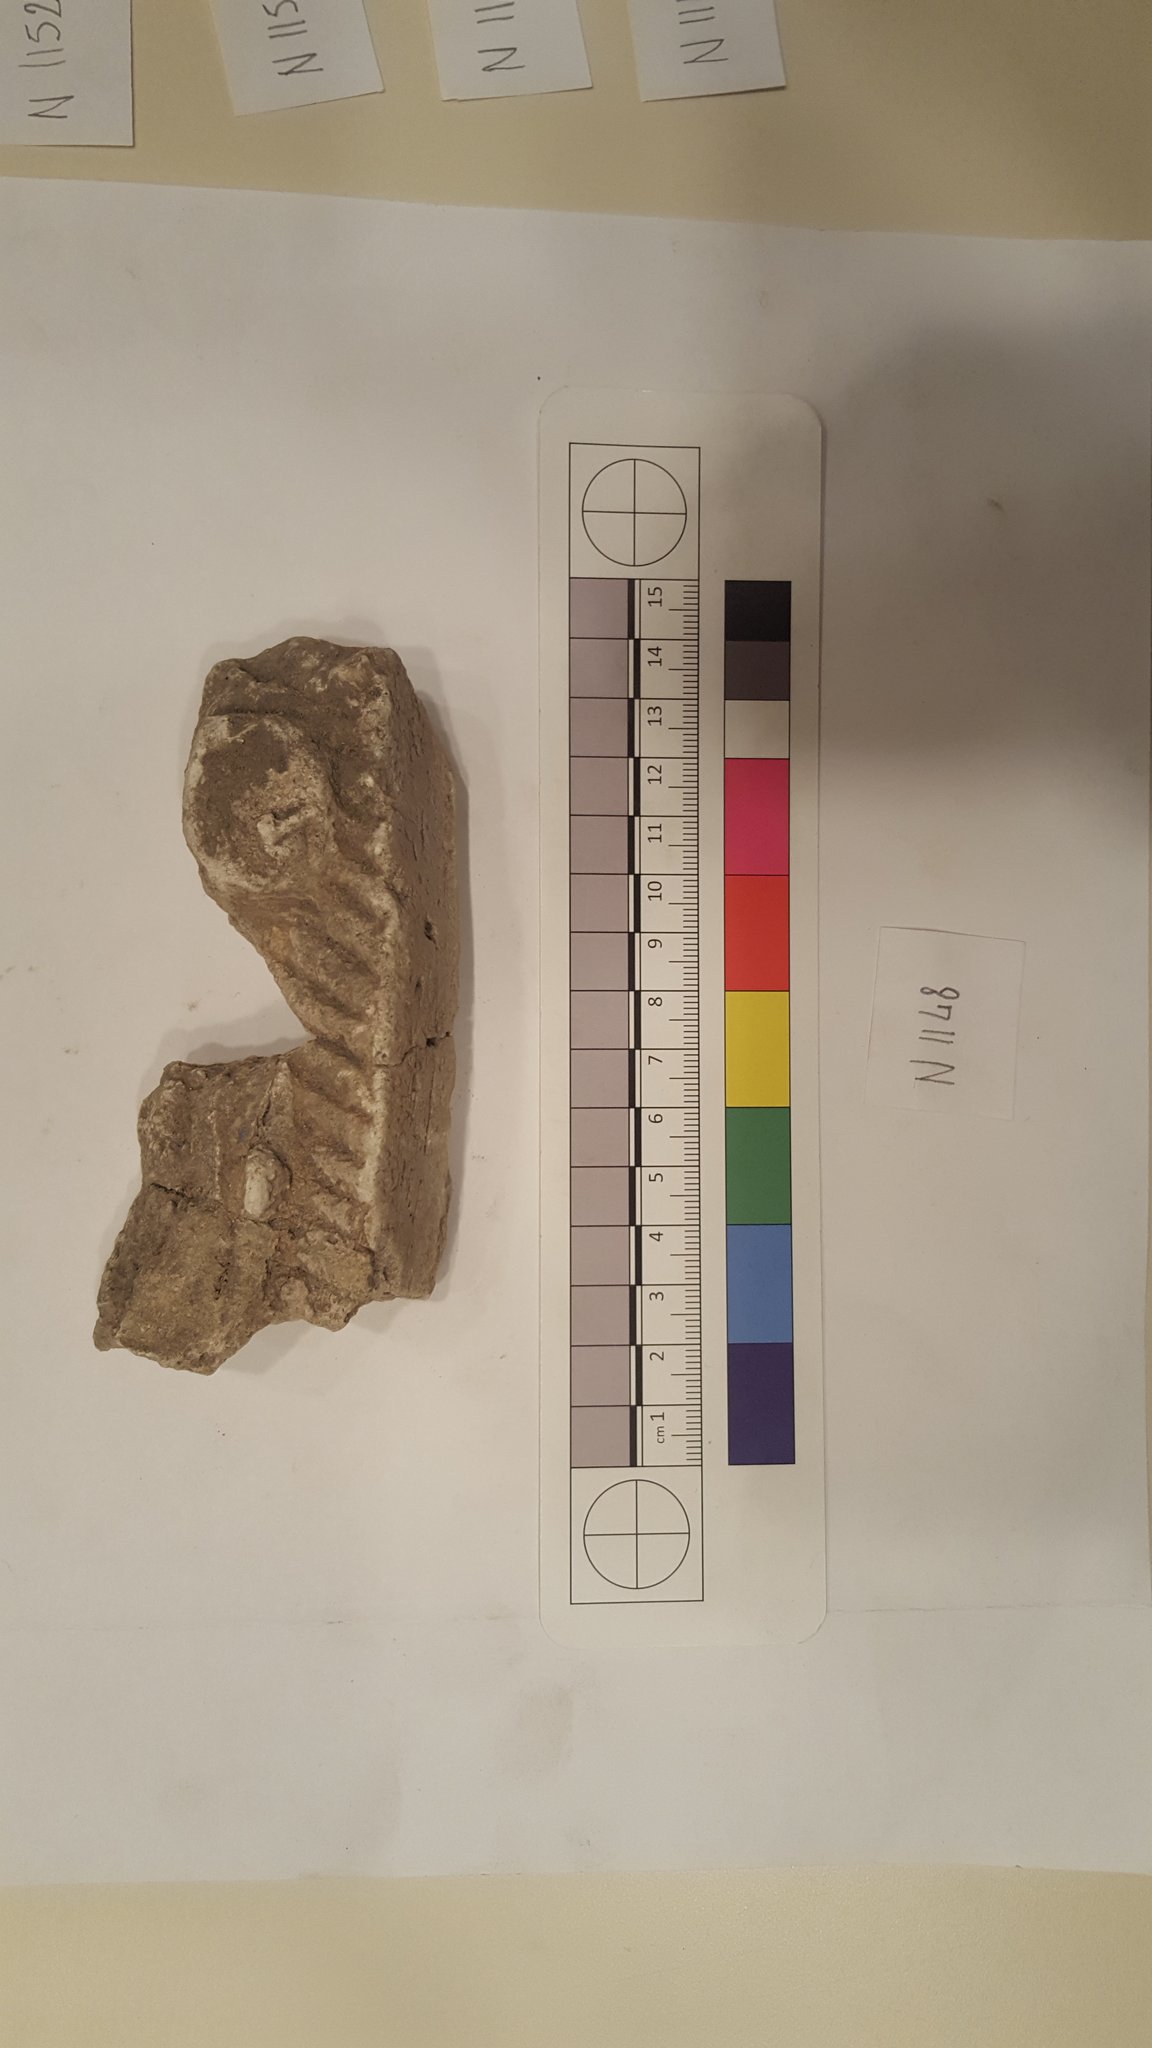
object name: fragment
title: Stucco Fragment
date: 701-1200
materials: plaster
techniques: carving, painting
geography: iran